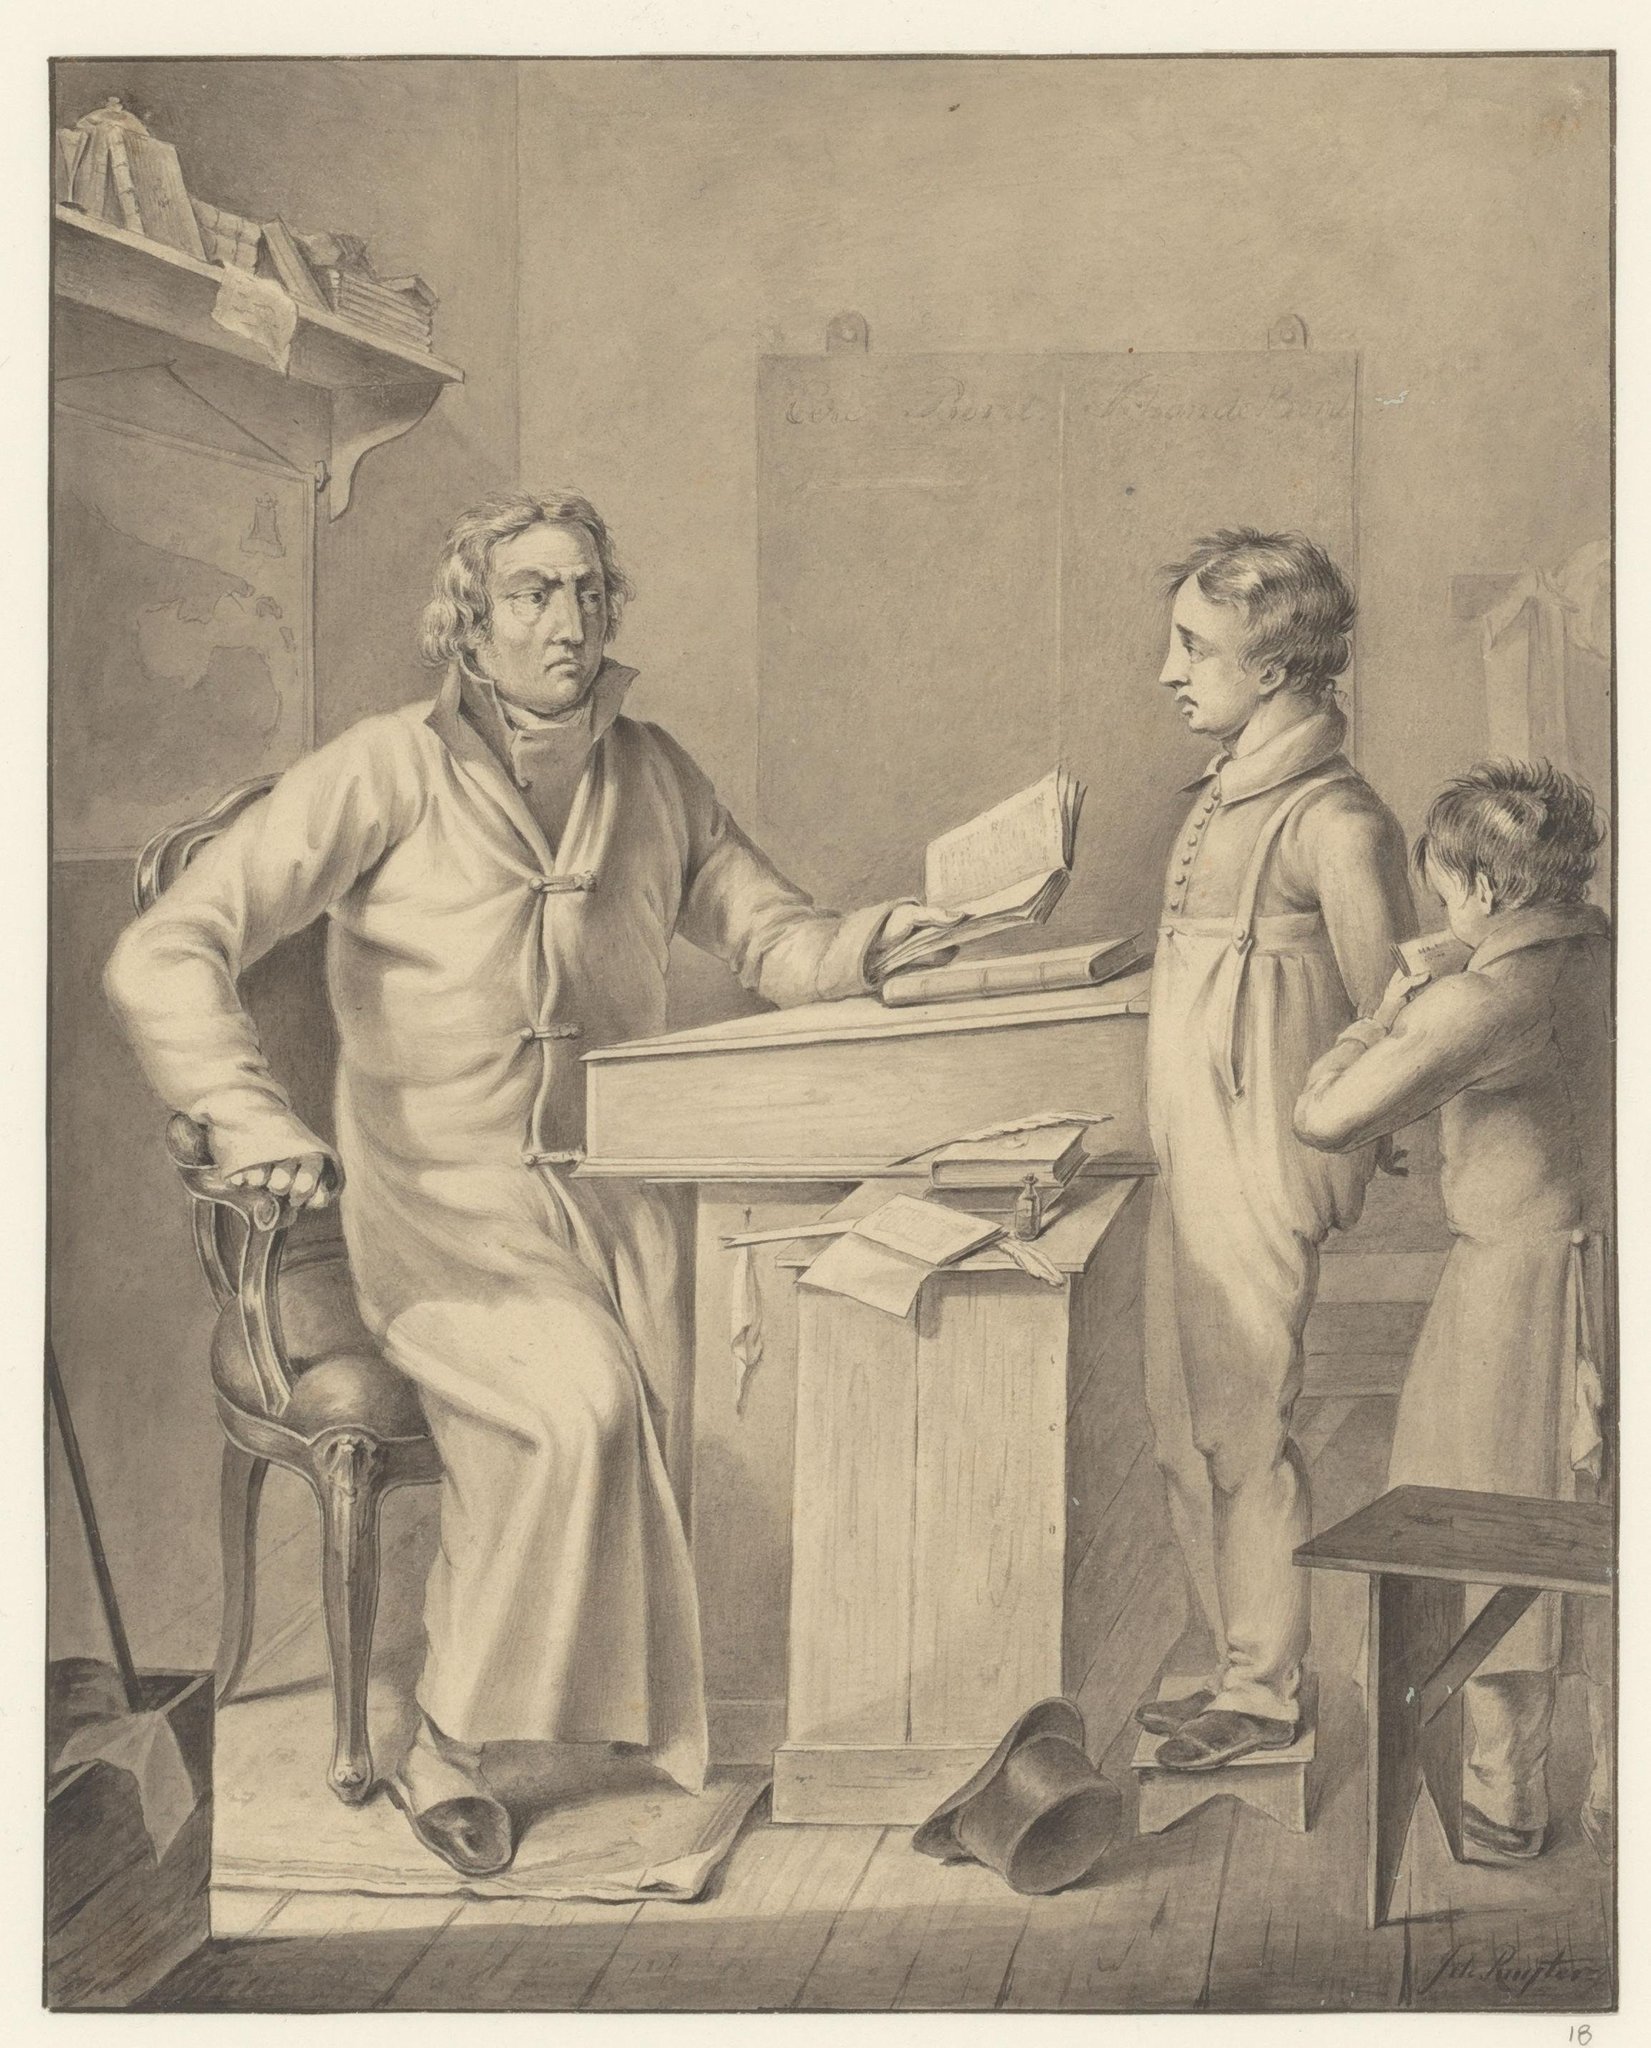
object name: drawing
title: Boze leraar achter zijn bureau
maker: jan de ruyter (ii)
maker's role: draughtsman, painter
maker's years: 1786-1831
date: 1819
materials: ink, paper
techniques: brush, pen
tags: teacher and pupil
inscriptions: collector's mark: Lugt 1641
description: Twee jongens aan het bureau van de leraar. Onderwerpsrubrieken binnen de Atlas Zeden en Gewoonten: Onderwijs en Wetenschappen, Opvoeding en Onderwijs, Schoolmeesters.